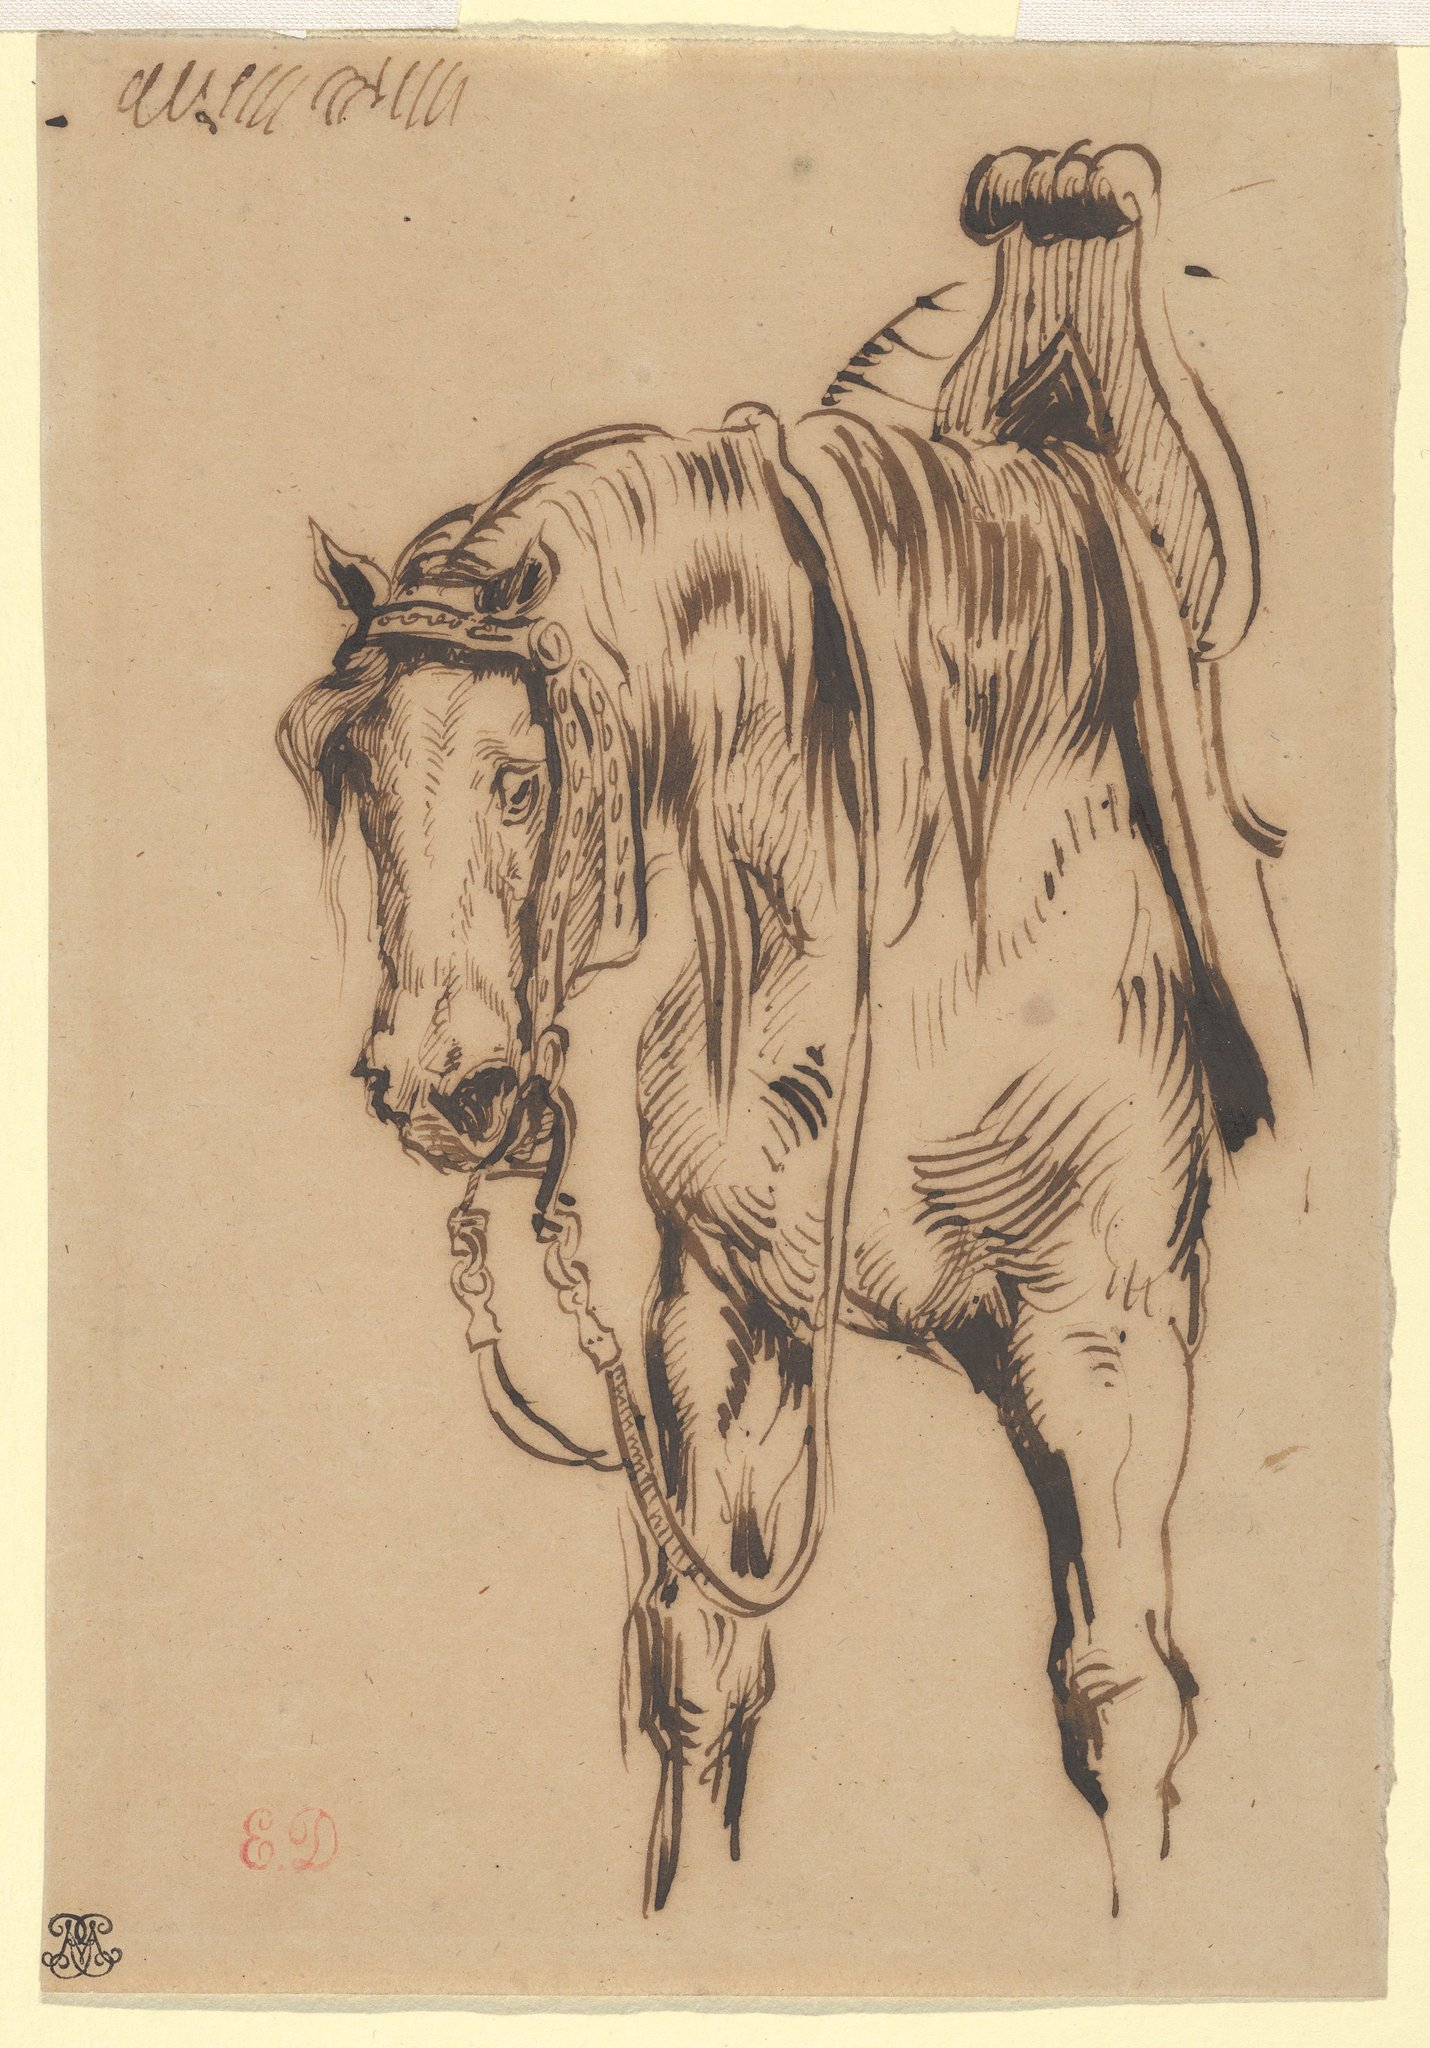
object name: drawing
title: Goetz van Berlichingen's Horse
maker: eugène delacroix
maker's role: artist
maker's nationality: french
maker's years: 1798-1863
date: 1842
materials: ink, iron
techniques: pen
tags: horses